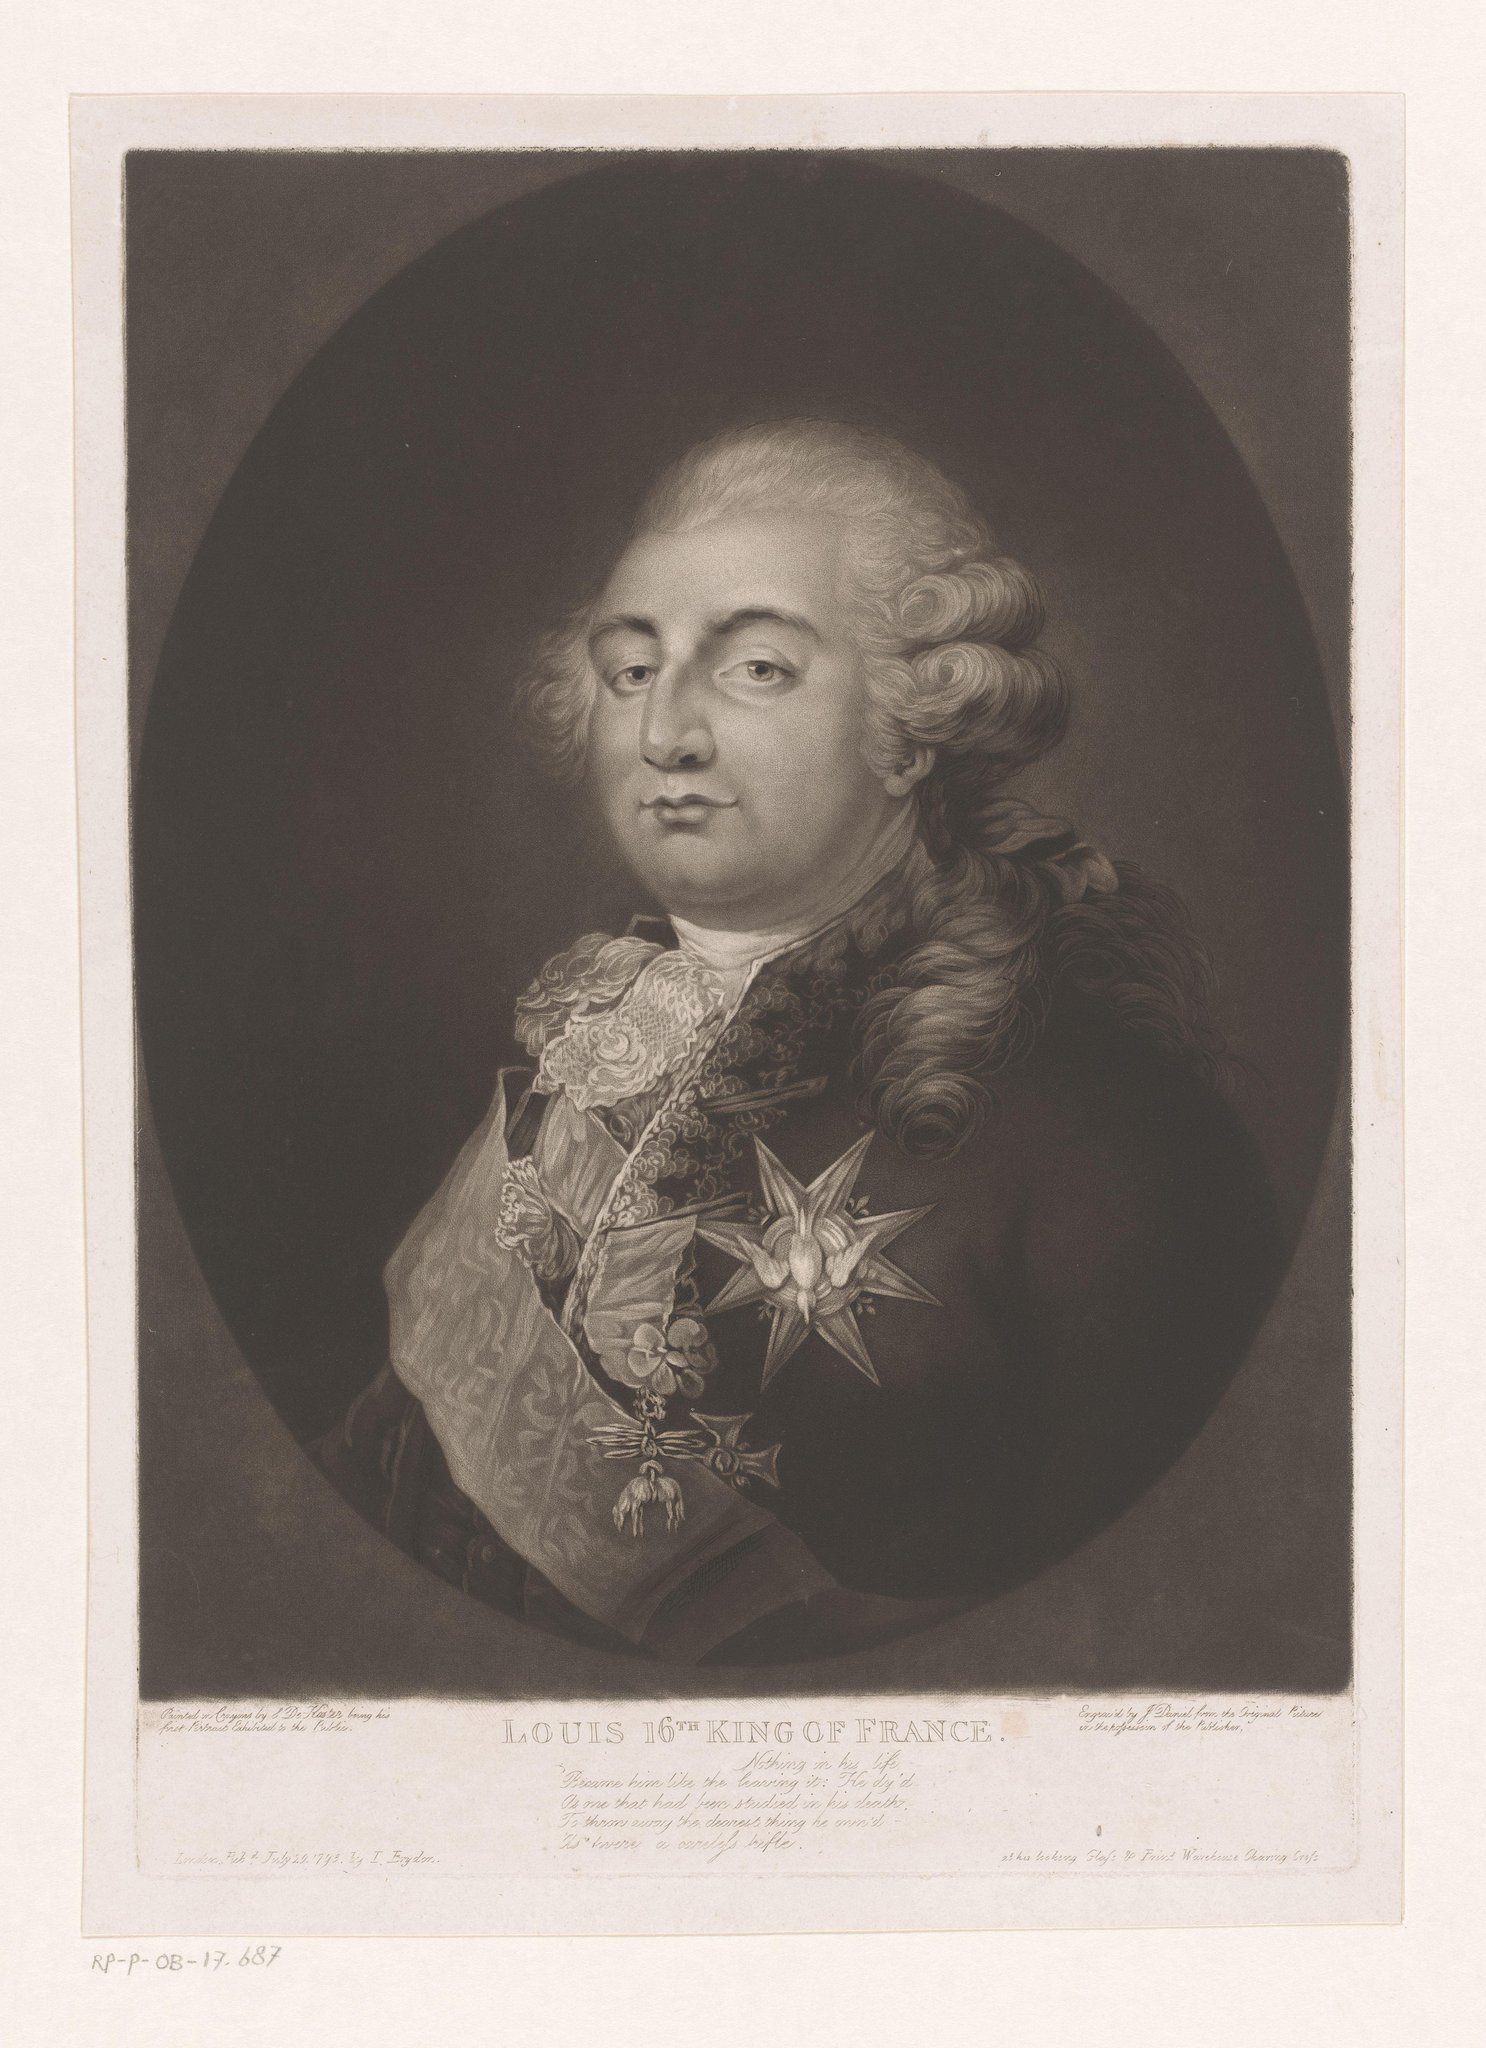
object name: print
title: Portret van Lodewijk XVI, koning van Frankrijk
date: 1793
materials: paper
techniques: etching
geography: london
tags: paris, lodewijk xvi (koning van frankrijk), historical persons, king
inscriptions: number: ‘Nr. 1217’, collector's mark: Lugt 2228